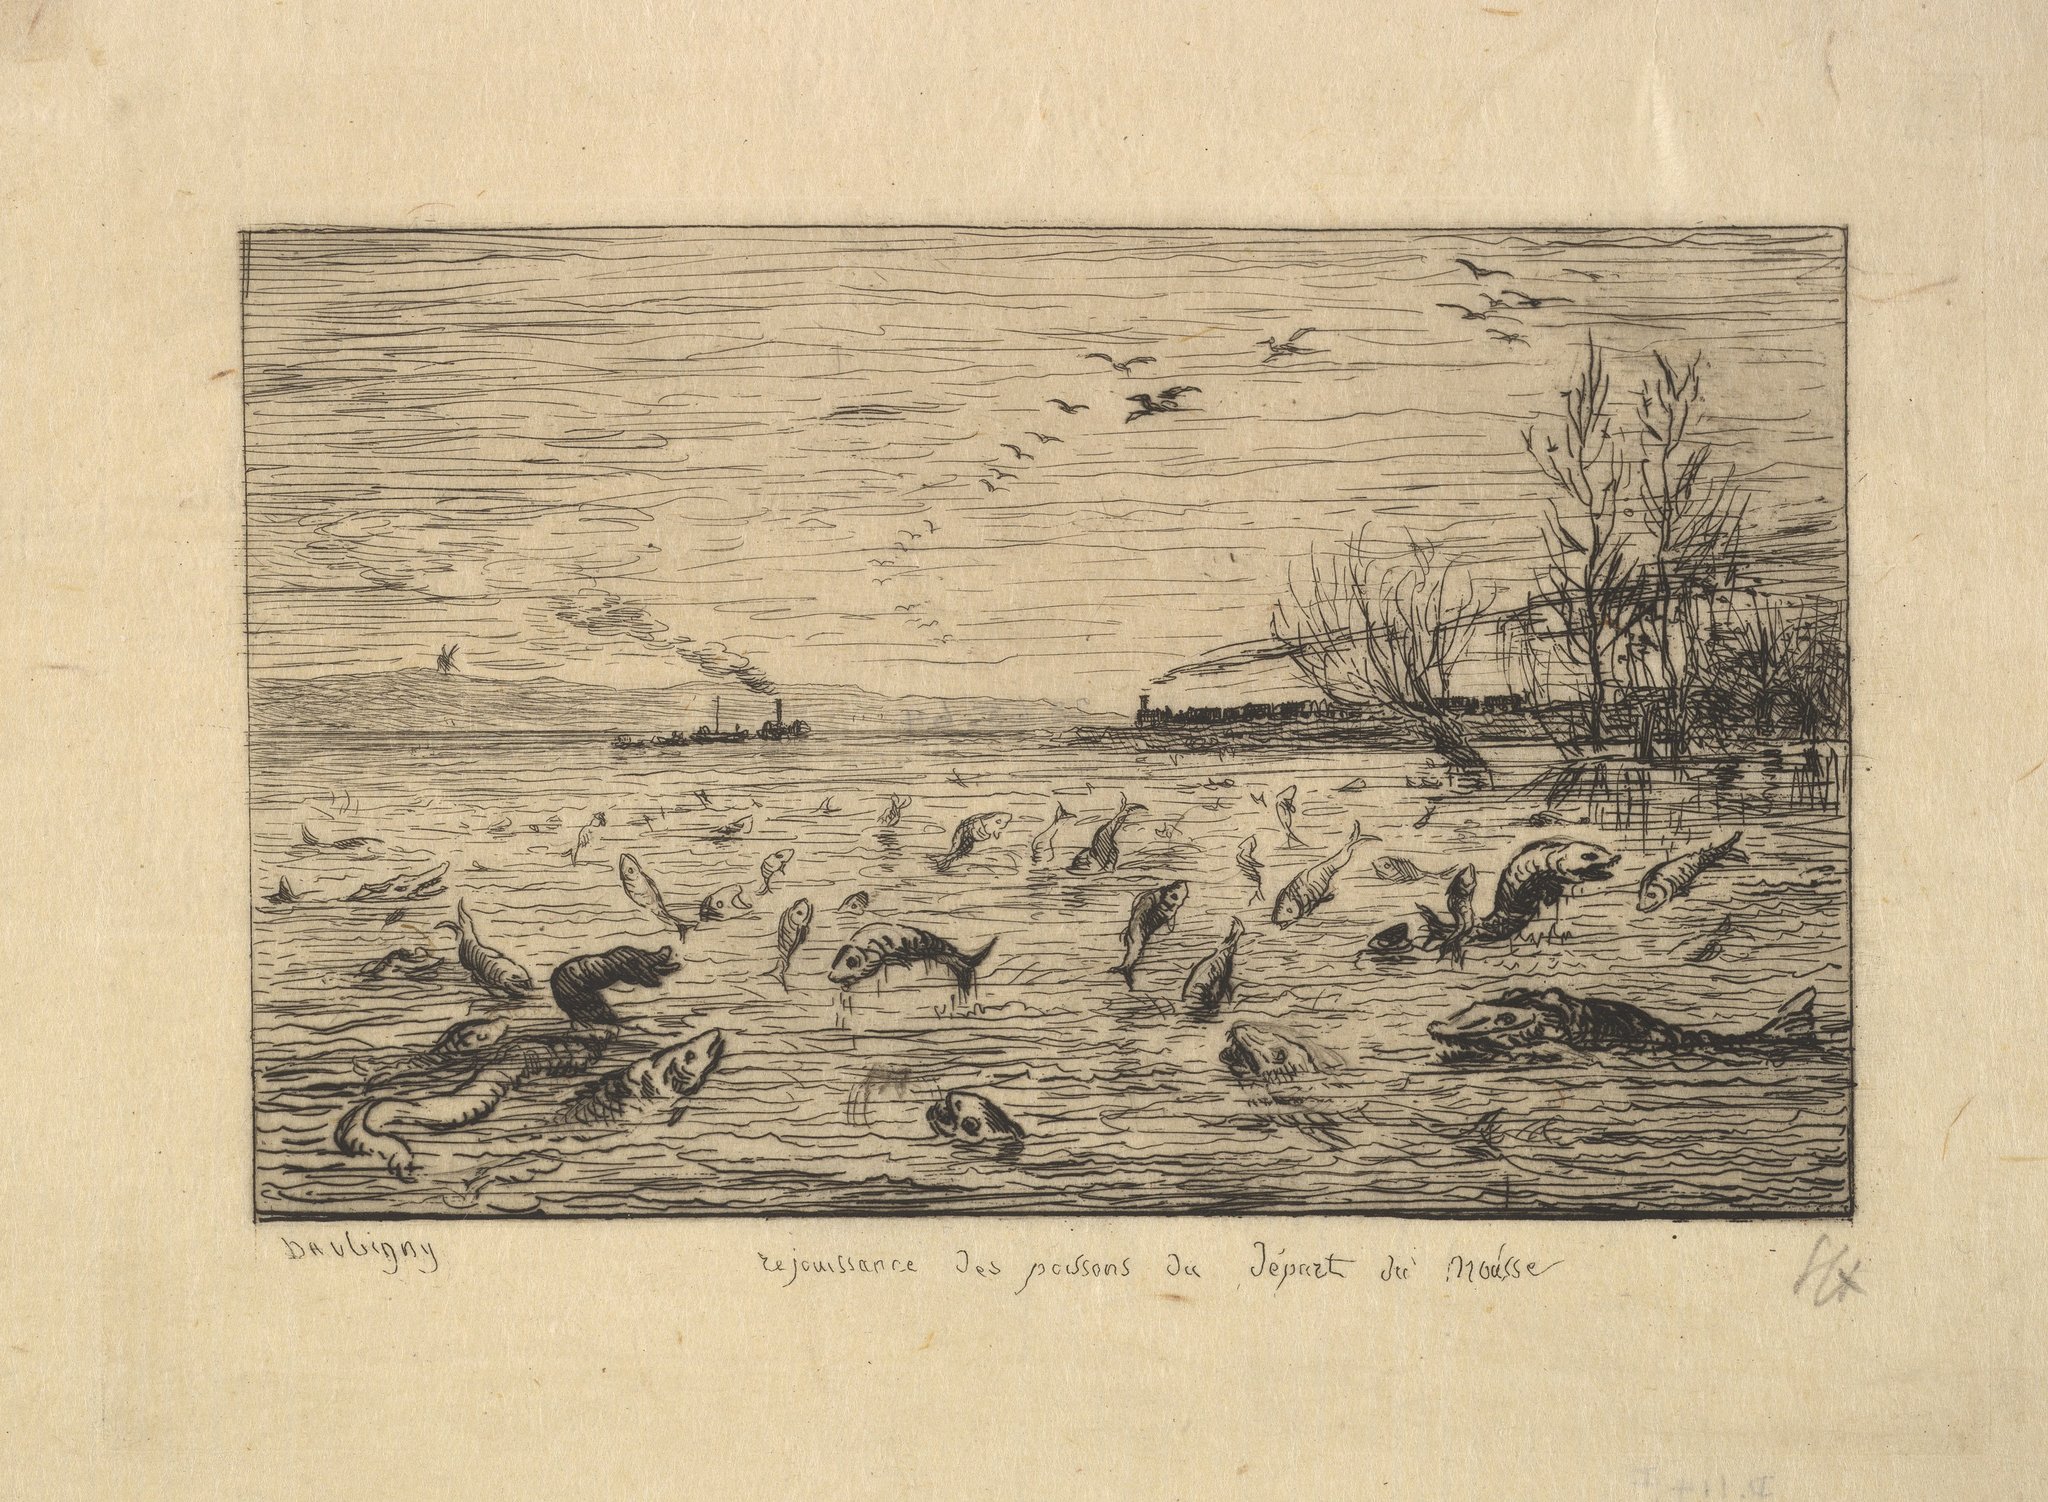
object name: print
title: The Fish Rejoice in the Departure of the Cabin Boy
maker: charles-françois daubigny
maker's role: artist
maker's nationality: french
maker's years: 1817-1878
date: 1861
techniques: etching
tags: fish,rivers,trains